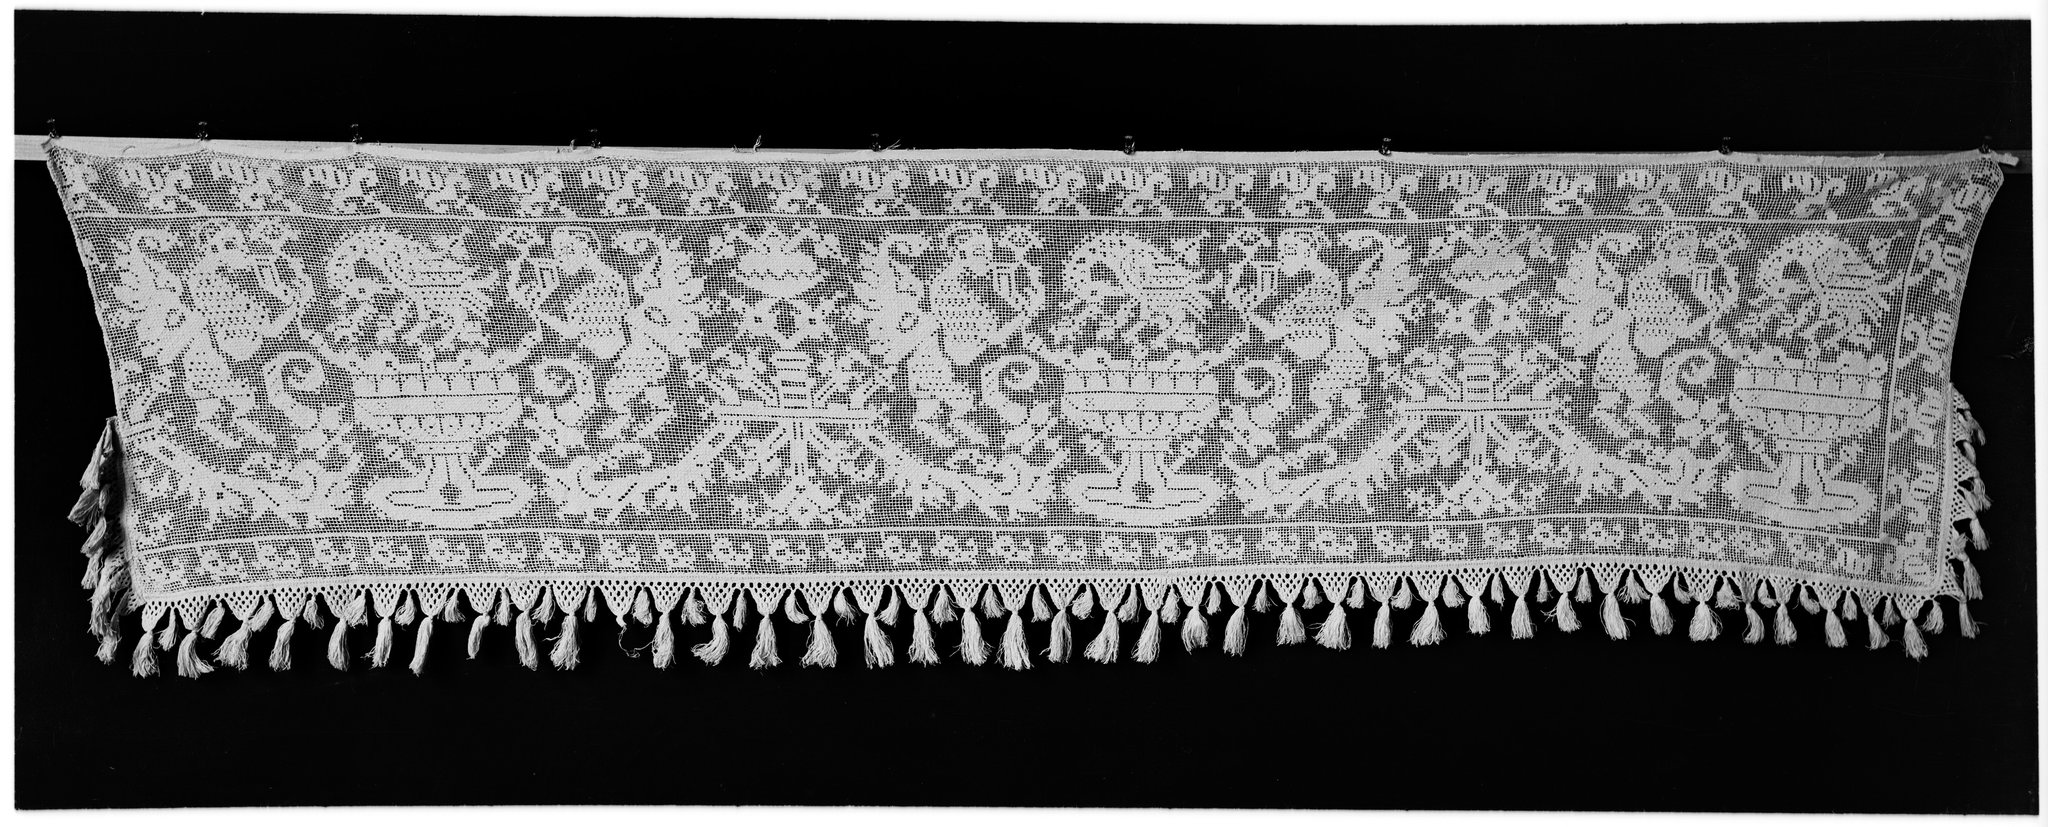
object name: altar frontal valance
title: Valance of an altar frontal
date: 1601-1700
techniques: embroidery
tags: birds